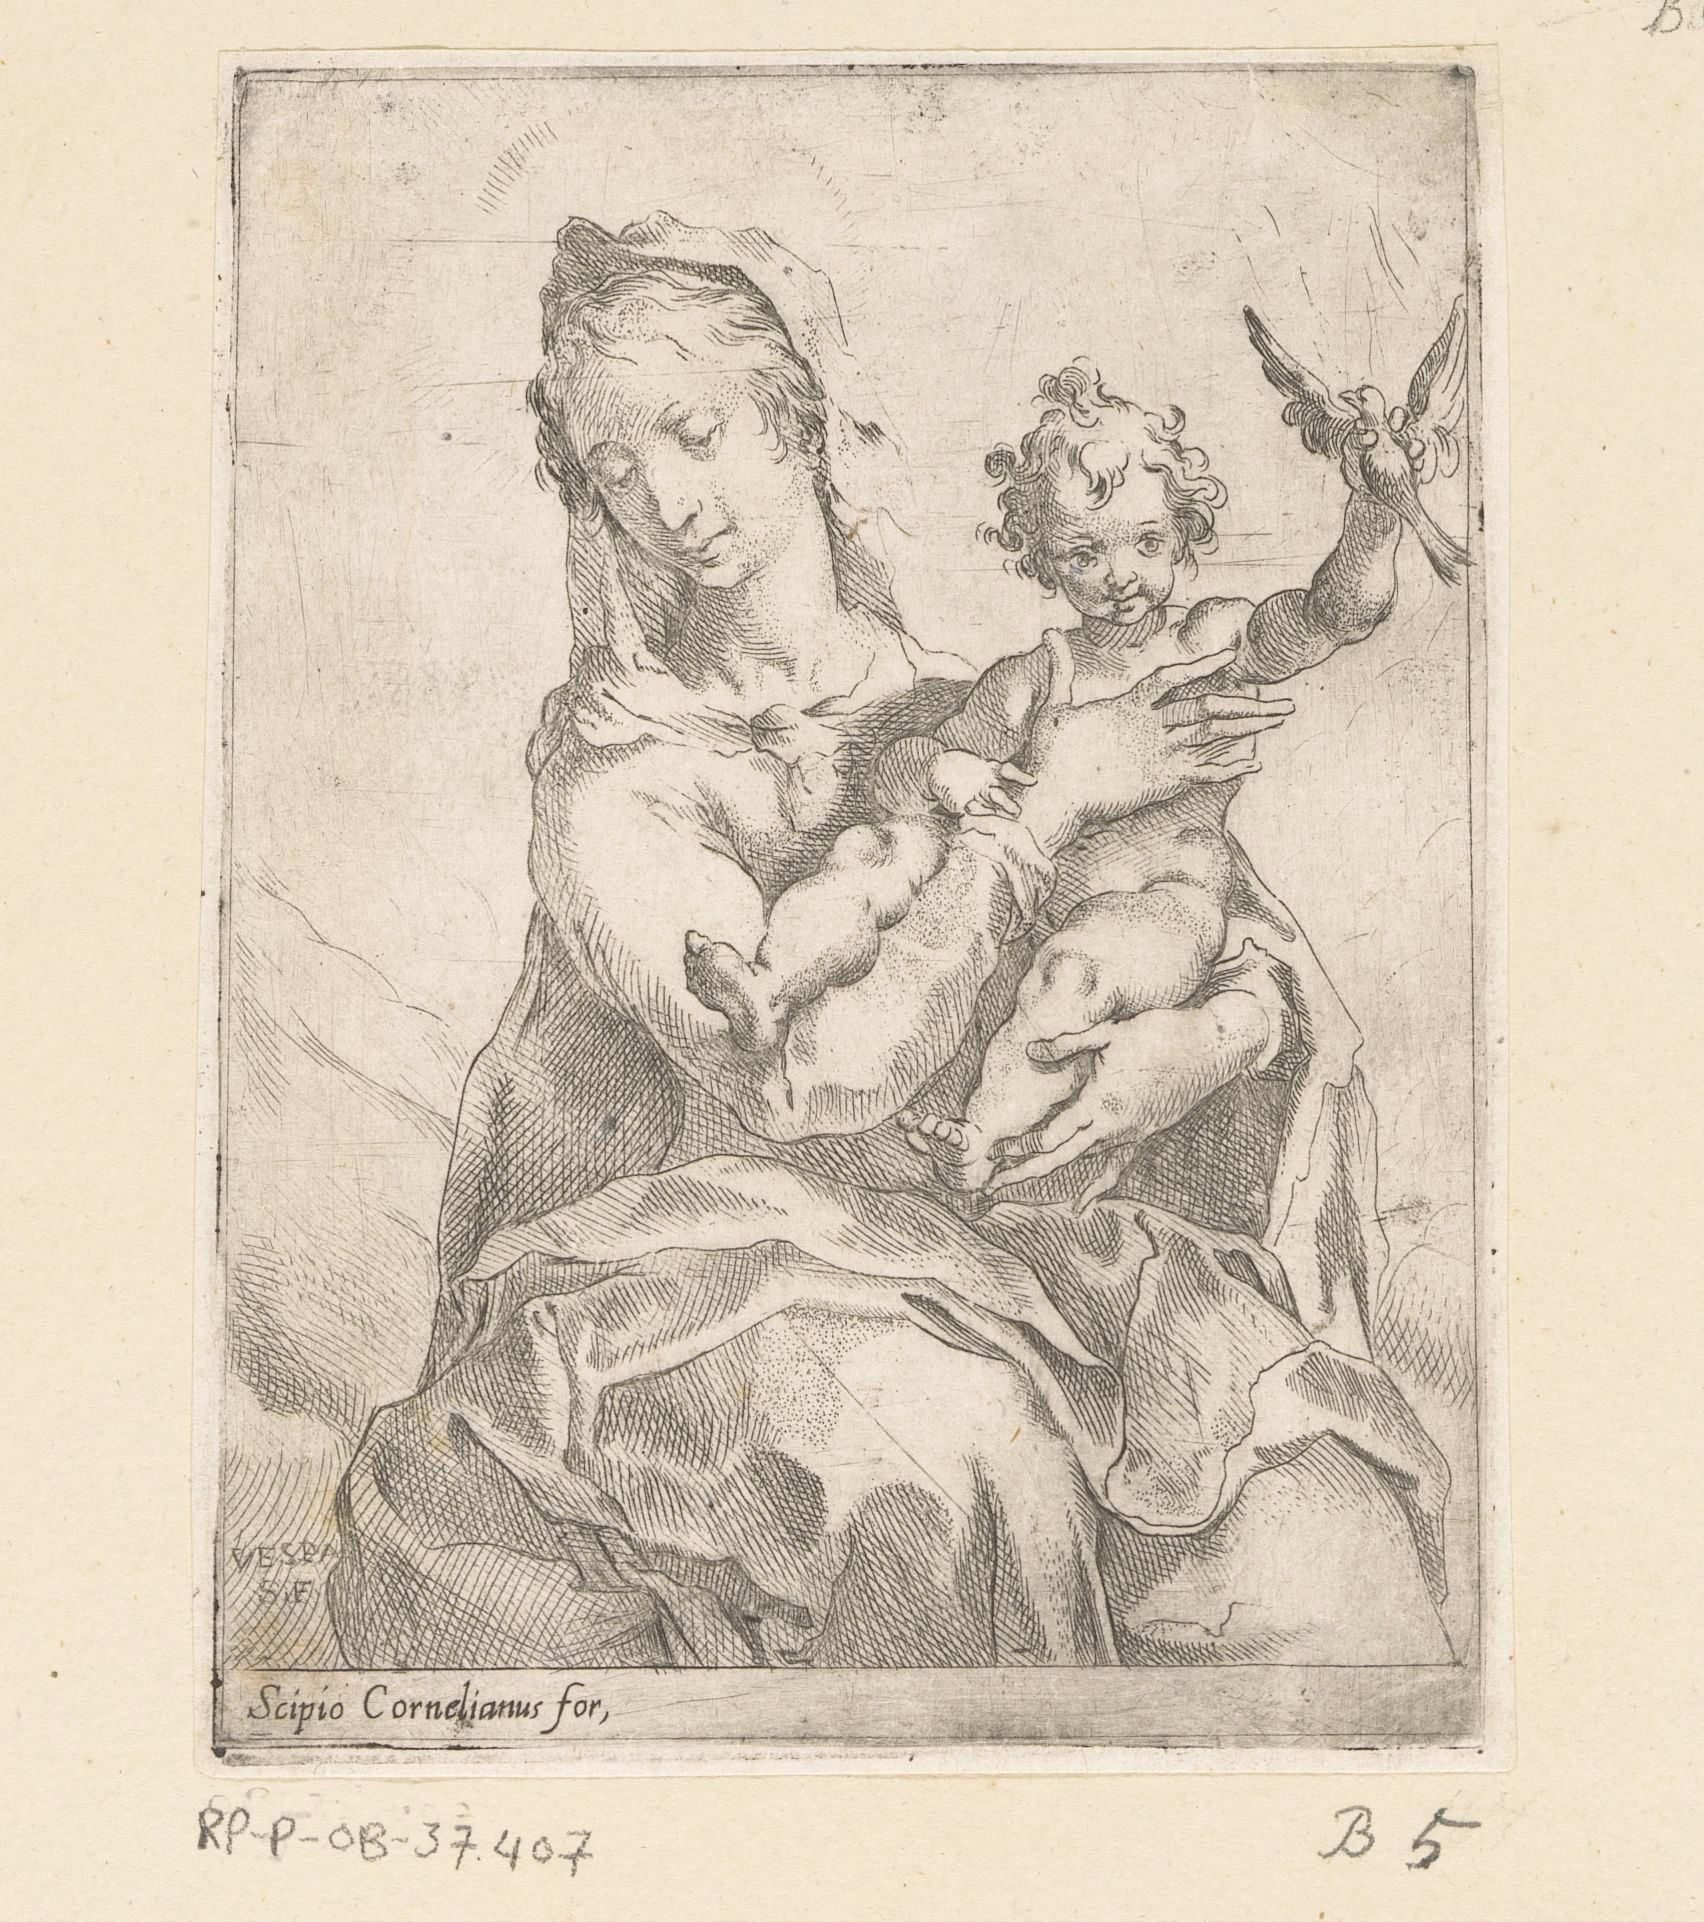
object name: print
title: Maria met Kind en vogel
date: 1592-1622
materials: paper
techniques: etching, intaglio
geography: italy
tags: madonna: i.e. mary with the christ-child, christ-child holding something in his hand, e.g. apple, bird, cherries, crucifix, grapes, paper wind-mill ~ madonna-representations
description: Maria zittend met het Christuskind in haar armen. In zijn linkerhand houdt het Kind een vogel vast.